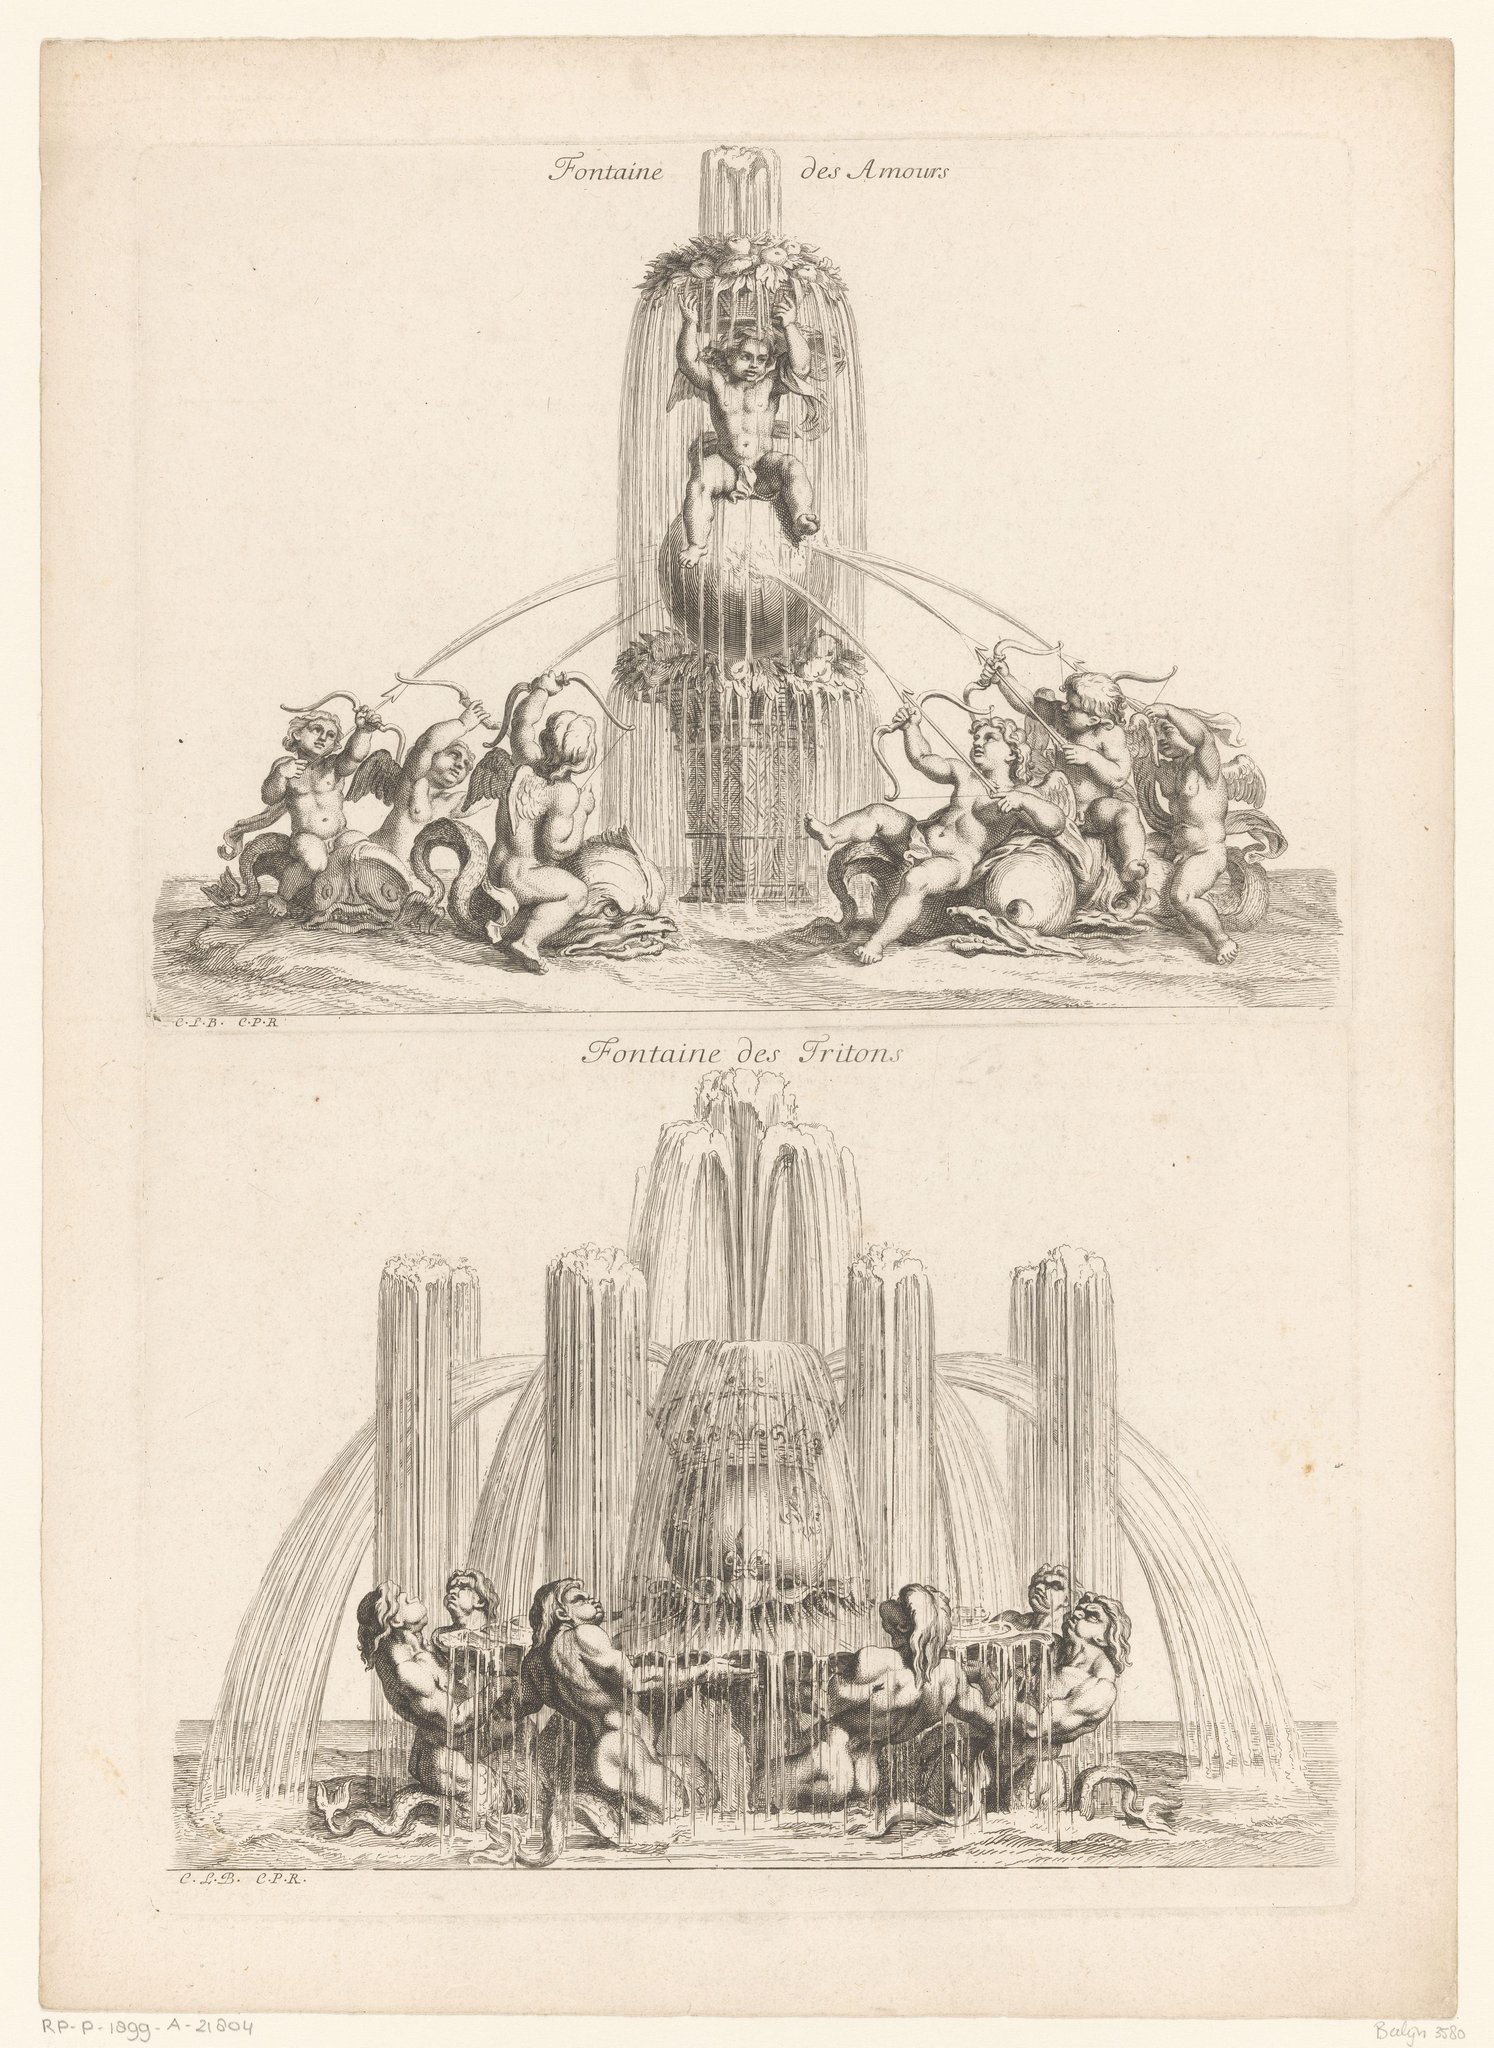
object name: print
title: Fonteinen met putti en meermannen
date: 1672-1686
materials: paper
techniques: etching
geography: paris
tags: merman, ornamental fountain, cupids: 'amores', 'amoretti', 'putti'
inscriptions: collector's mark: Lugt 2228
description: Twee fonteinen op een blad. Boven: Een fontein met een globe rustend op een mand met bloemen. Op de globe zit een putto met een bloemenmand. Rondom zitten zes putti met pijl en boog op dolfijnen. Onder: Een fontein in schelpvorm gedragen door zes meermannen. Op de schelp het gekroonde wapen van Frankrijk.